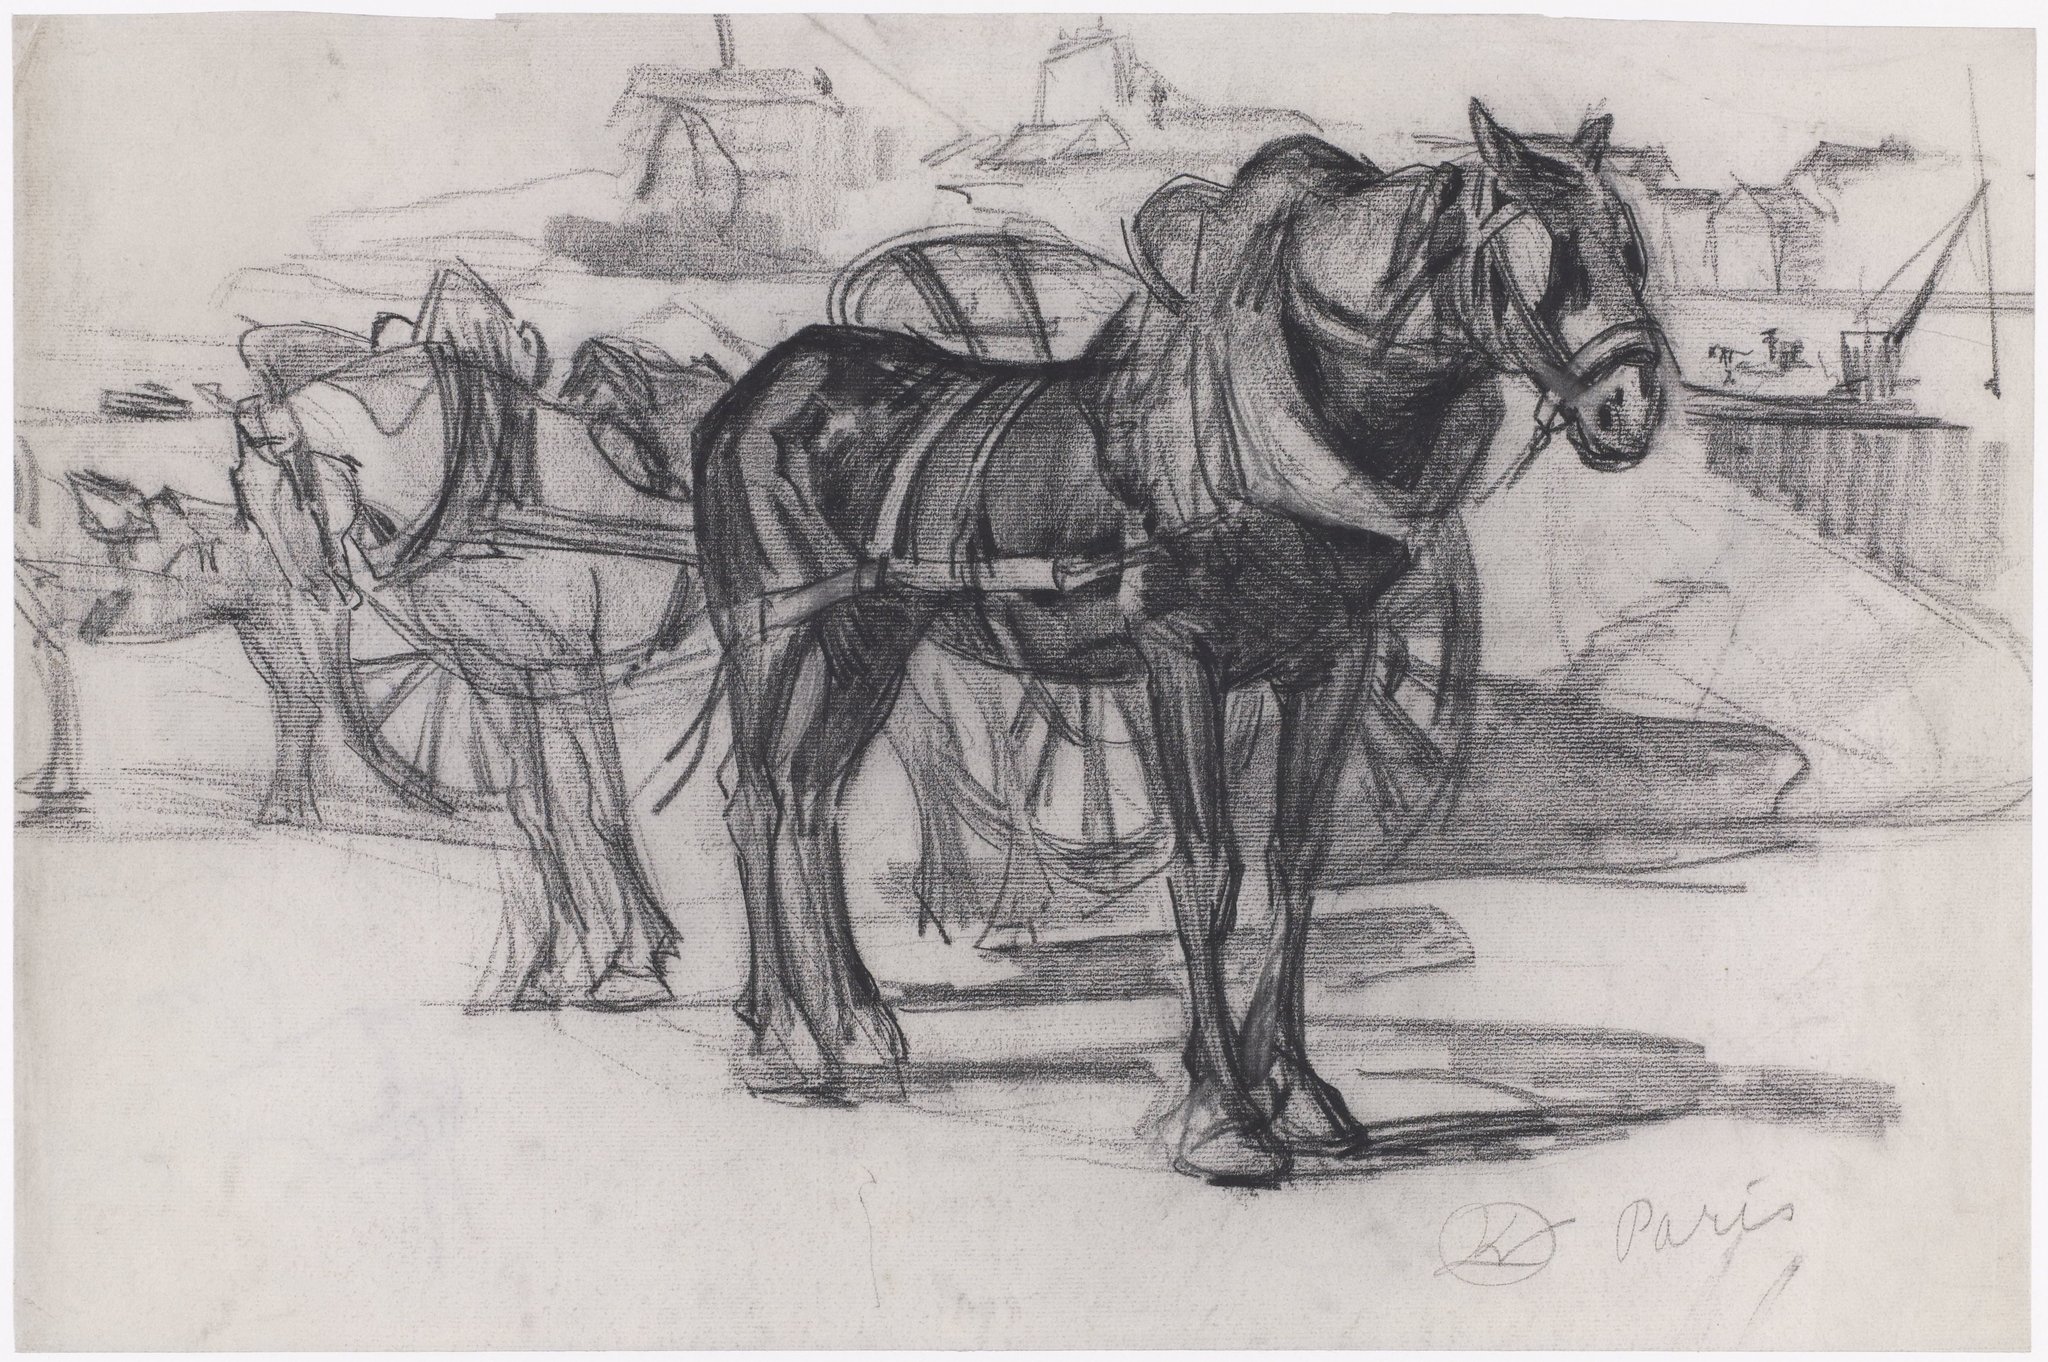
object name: drawing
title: Studie van paarden voor een zandkar te Parijs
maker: gerrit willem dijsselhof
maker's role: designer, draughtsman, print maker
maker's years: 1866-1924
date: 1876-1924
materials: chalk, paper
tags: horse, two-wheeled vehicle drawn by one animal, paris